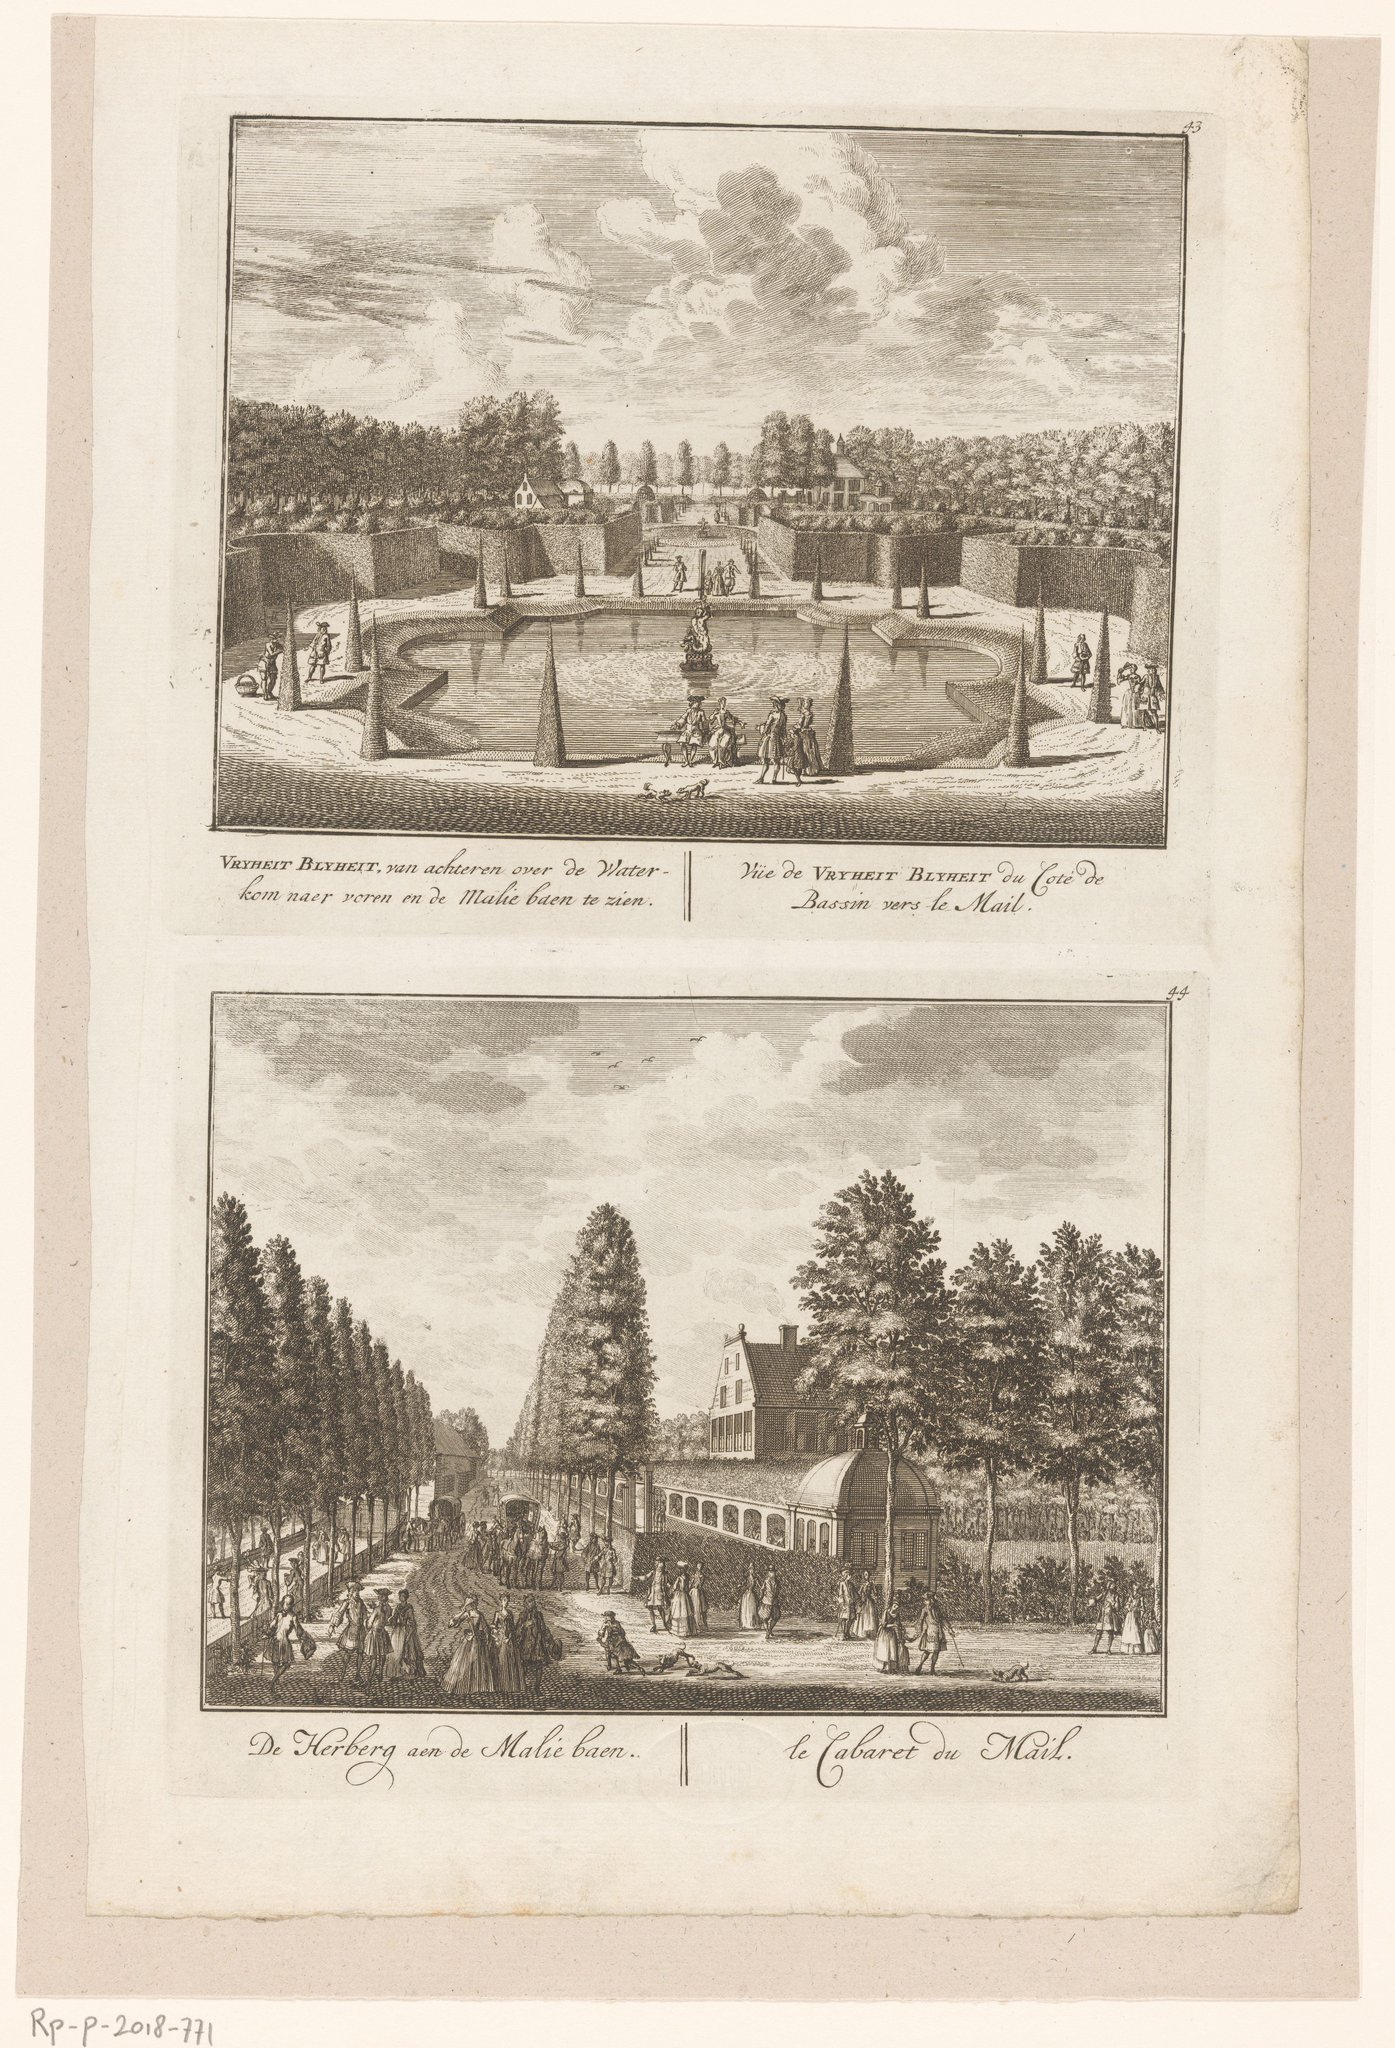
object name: print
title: Vryheit Blyheit, van achteren over de waterkom naer voren en de Malie Baen te zien / Vüe de Vryheit Blyheit du coté de bassin vers le Mail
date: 1725-1768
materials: paper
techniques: engraving, etching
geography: amsterdam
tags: french or architectonic garden; formal garden, garden pond, hotel, hostelry, inn, country-house, amsterdam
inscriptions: check stamp: ‘Archief Ministerie van Oorlog Afdeeling Genie’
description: Prent gebruikt in: Niedek, Mattaeus Brouërius. Het verheerlykt Watergraafs- of Diemermeer by de stadt Amsterdam (...). Amsterdam: Andries en Hendrik de Leth, 1725. Of in: Niedek, Mattaeus Brouërius. Het verheerlykt Watergraafs- of Diemermeer by de stadt Amsterdam (...). Amsterdam: Pieter Jan Entrop, 1768.